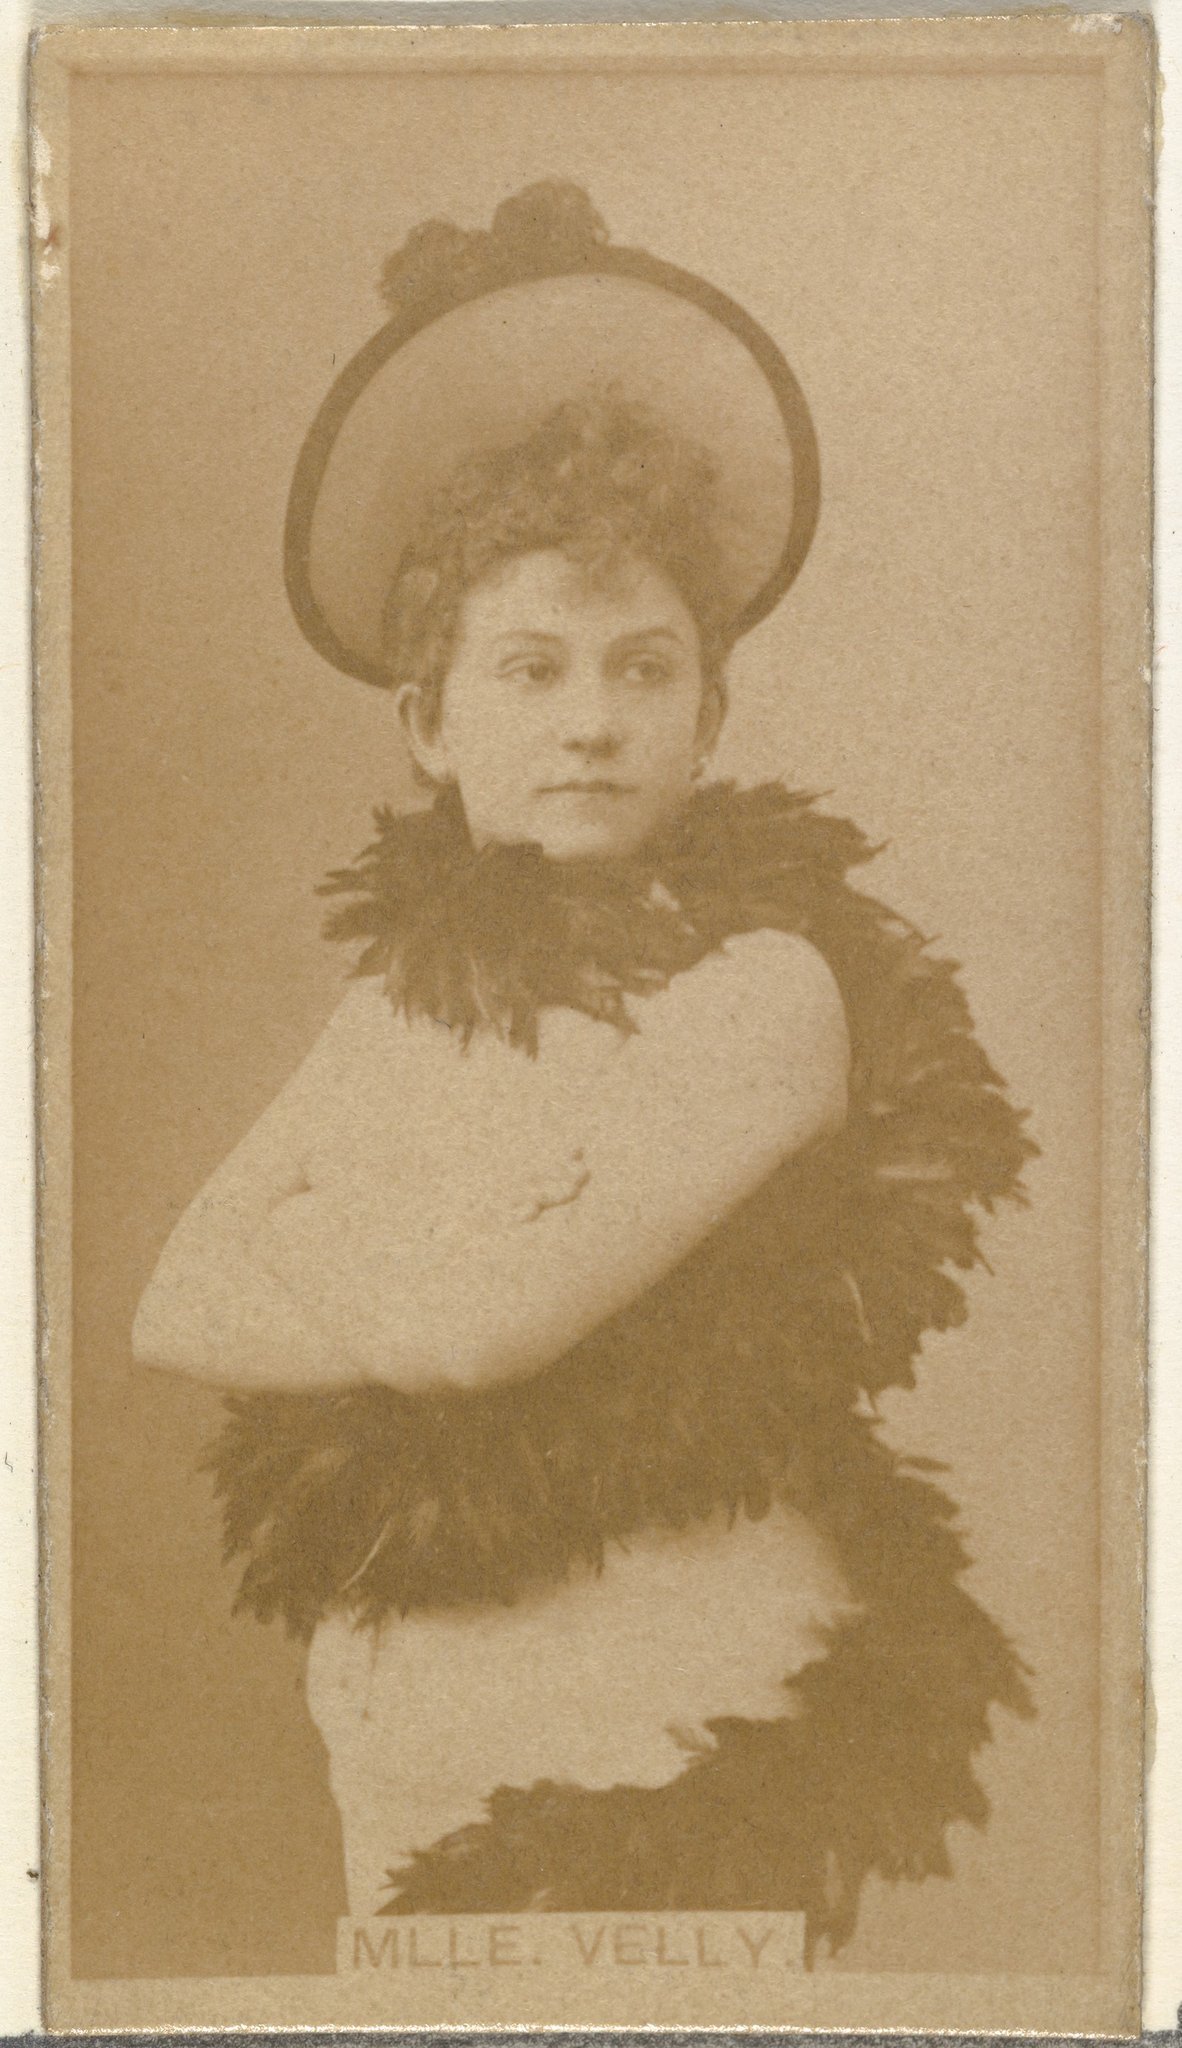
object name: photograph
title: Mlle. Velly, from the Actors and Actresses series (N145-8) issued by Duke Sons & Co. to promote Duke Cigarettes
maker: w. duke, sons & co.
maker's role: publisher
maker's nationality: american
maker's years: 1870-1920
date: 1891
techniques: albumen silver print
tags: portraits,women,actresses